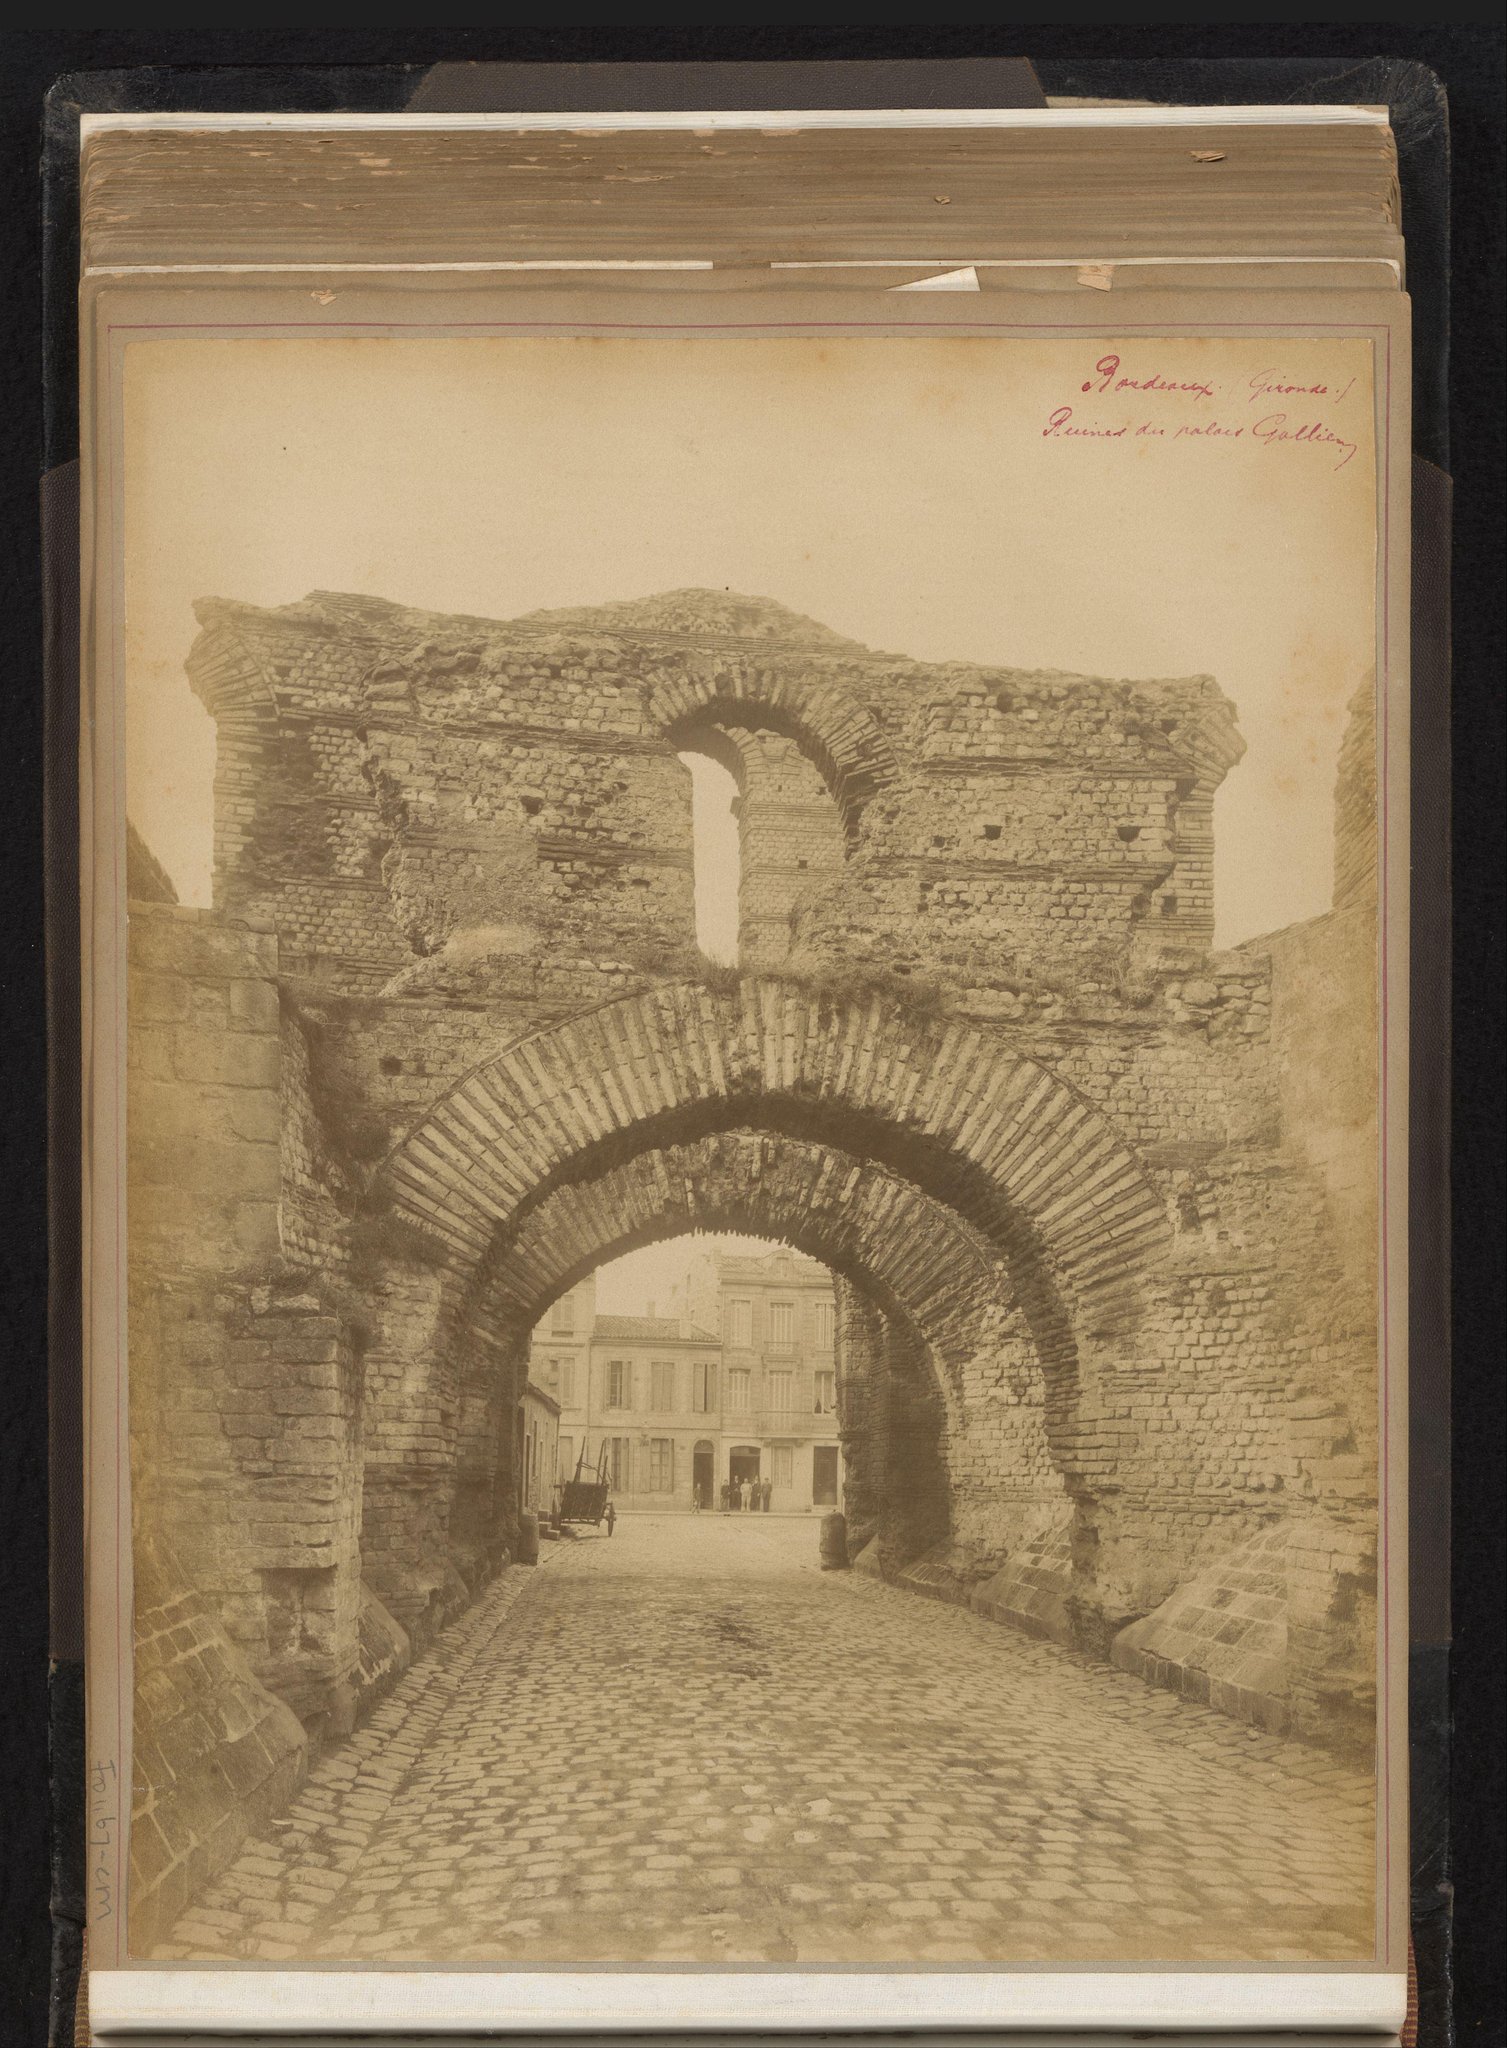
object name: album leaf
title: Ruïnes van het amfitheater van Bordeaux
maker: Anonymous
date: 1880-1910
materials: photographic support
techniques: albumen print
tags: ruin of a building ~ architecture, amphitheatre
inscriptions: annotation: ‘Bordeaux Gironde/ Ruines du palace Gallien’